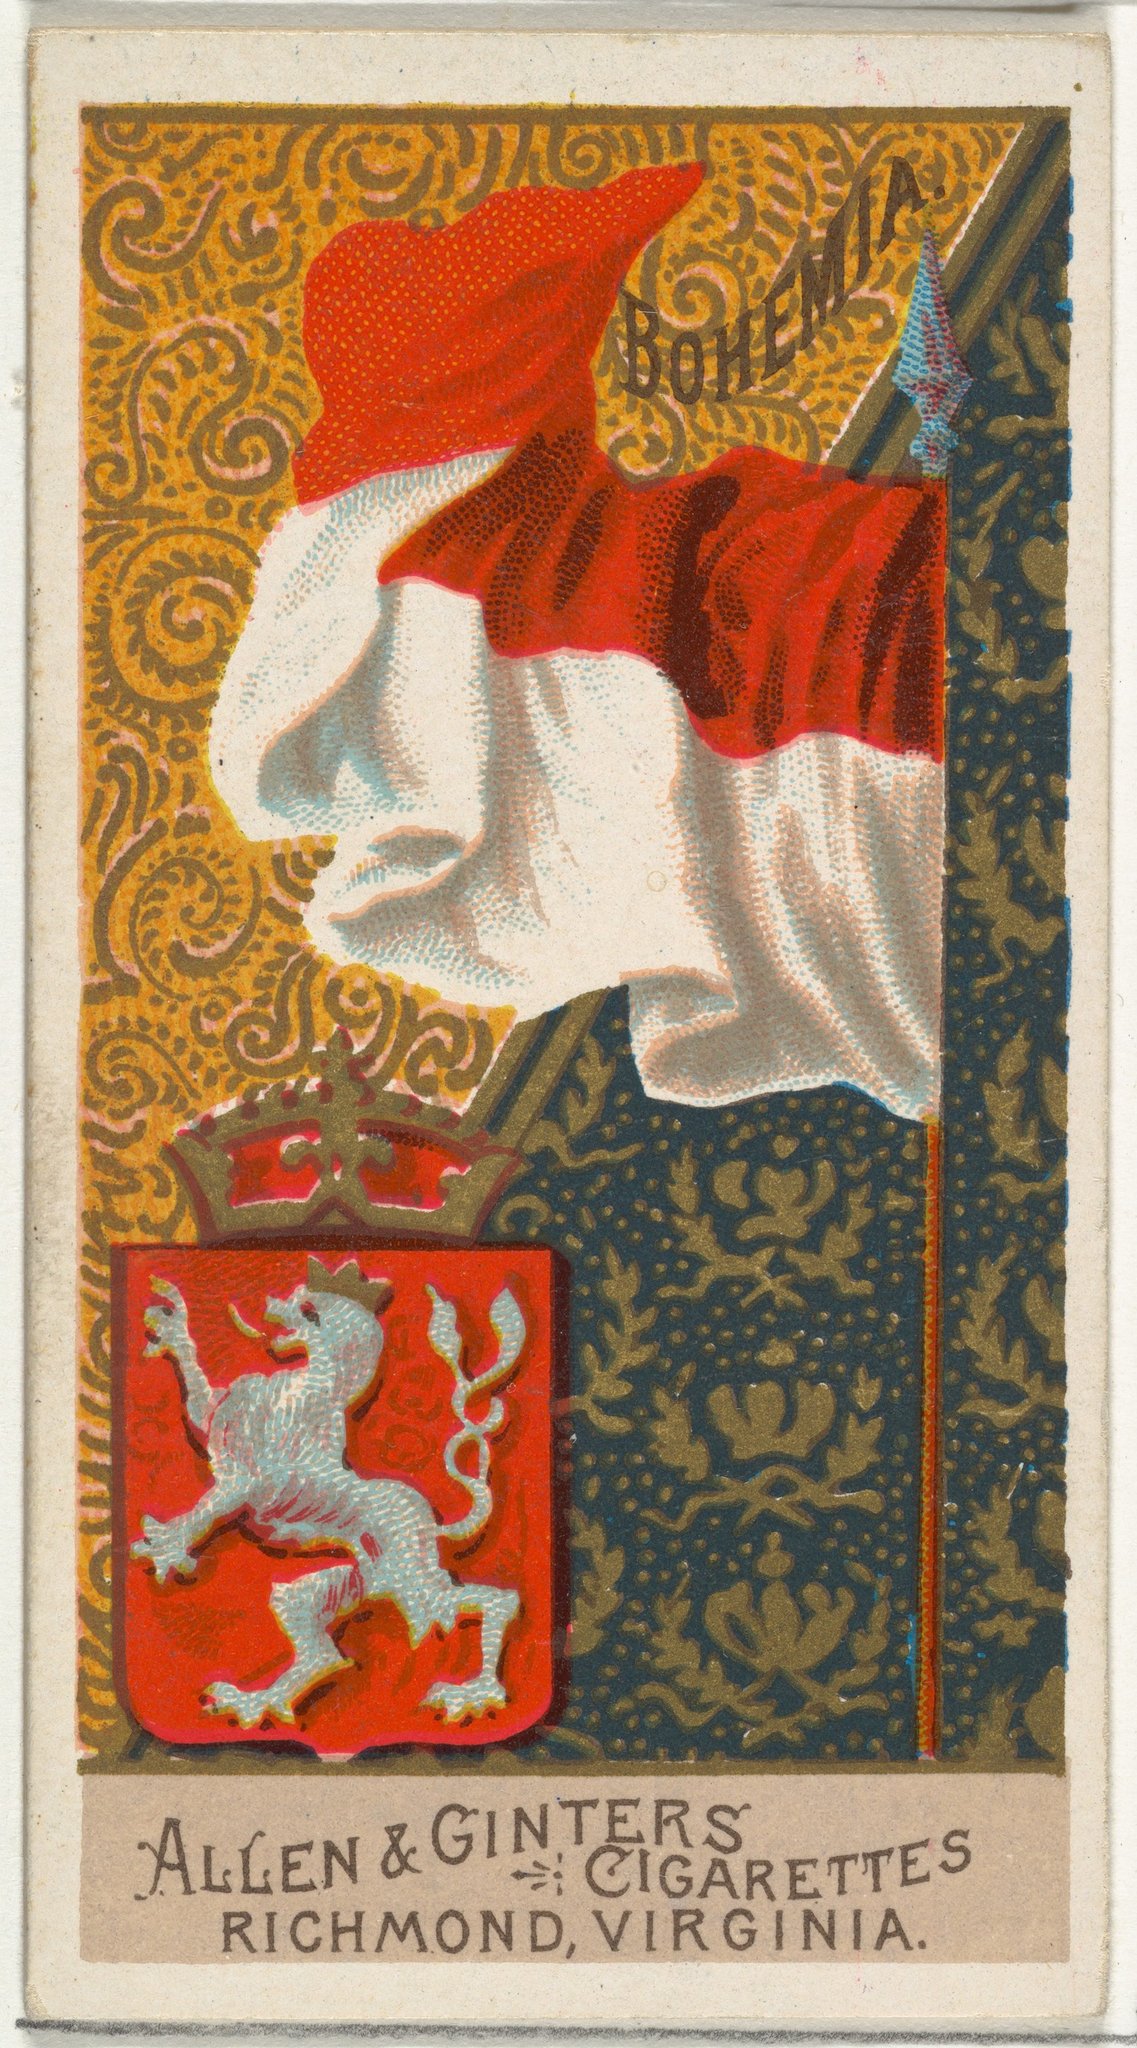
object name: print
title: Bohemia, from Flags of All Nations, Series 2 (N10) for Allen & Ginter Cigarettes Brands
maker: allen & ginter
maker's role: publisher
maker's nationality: american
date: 1890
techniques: color lithograph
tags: coat of arms,flags